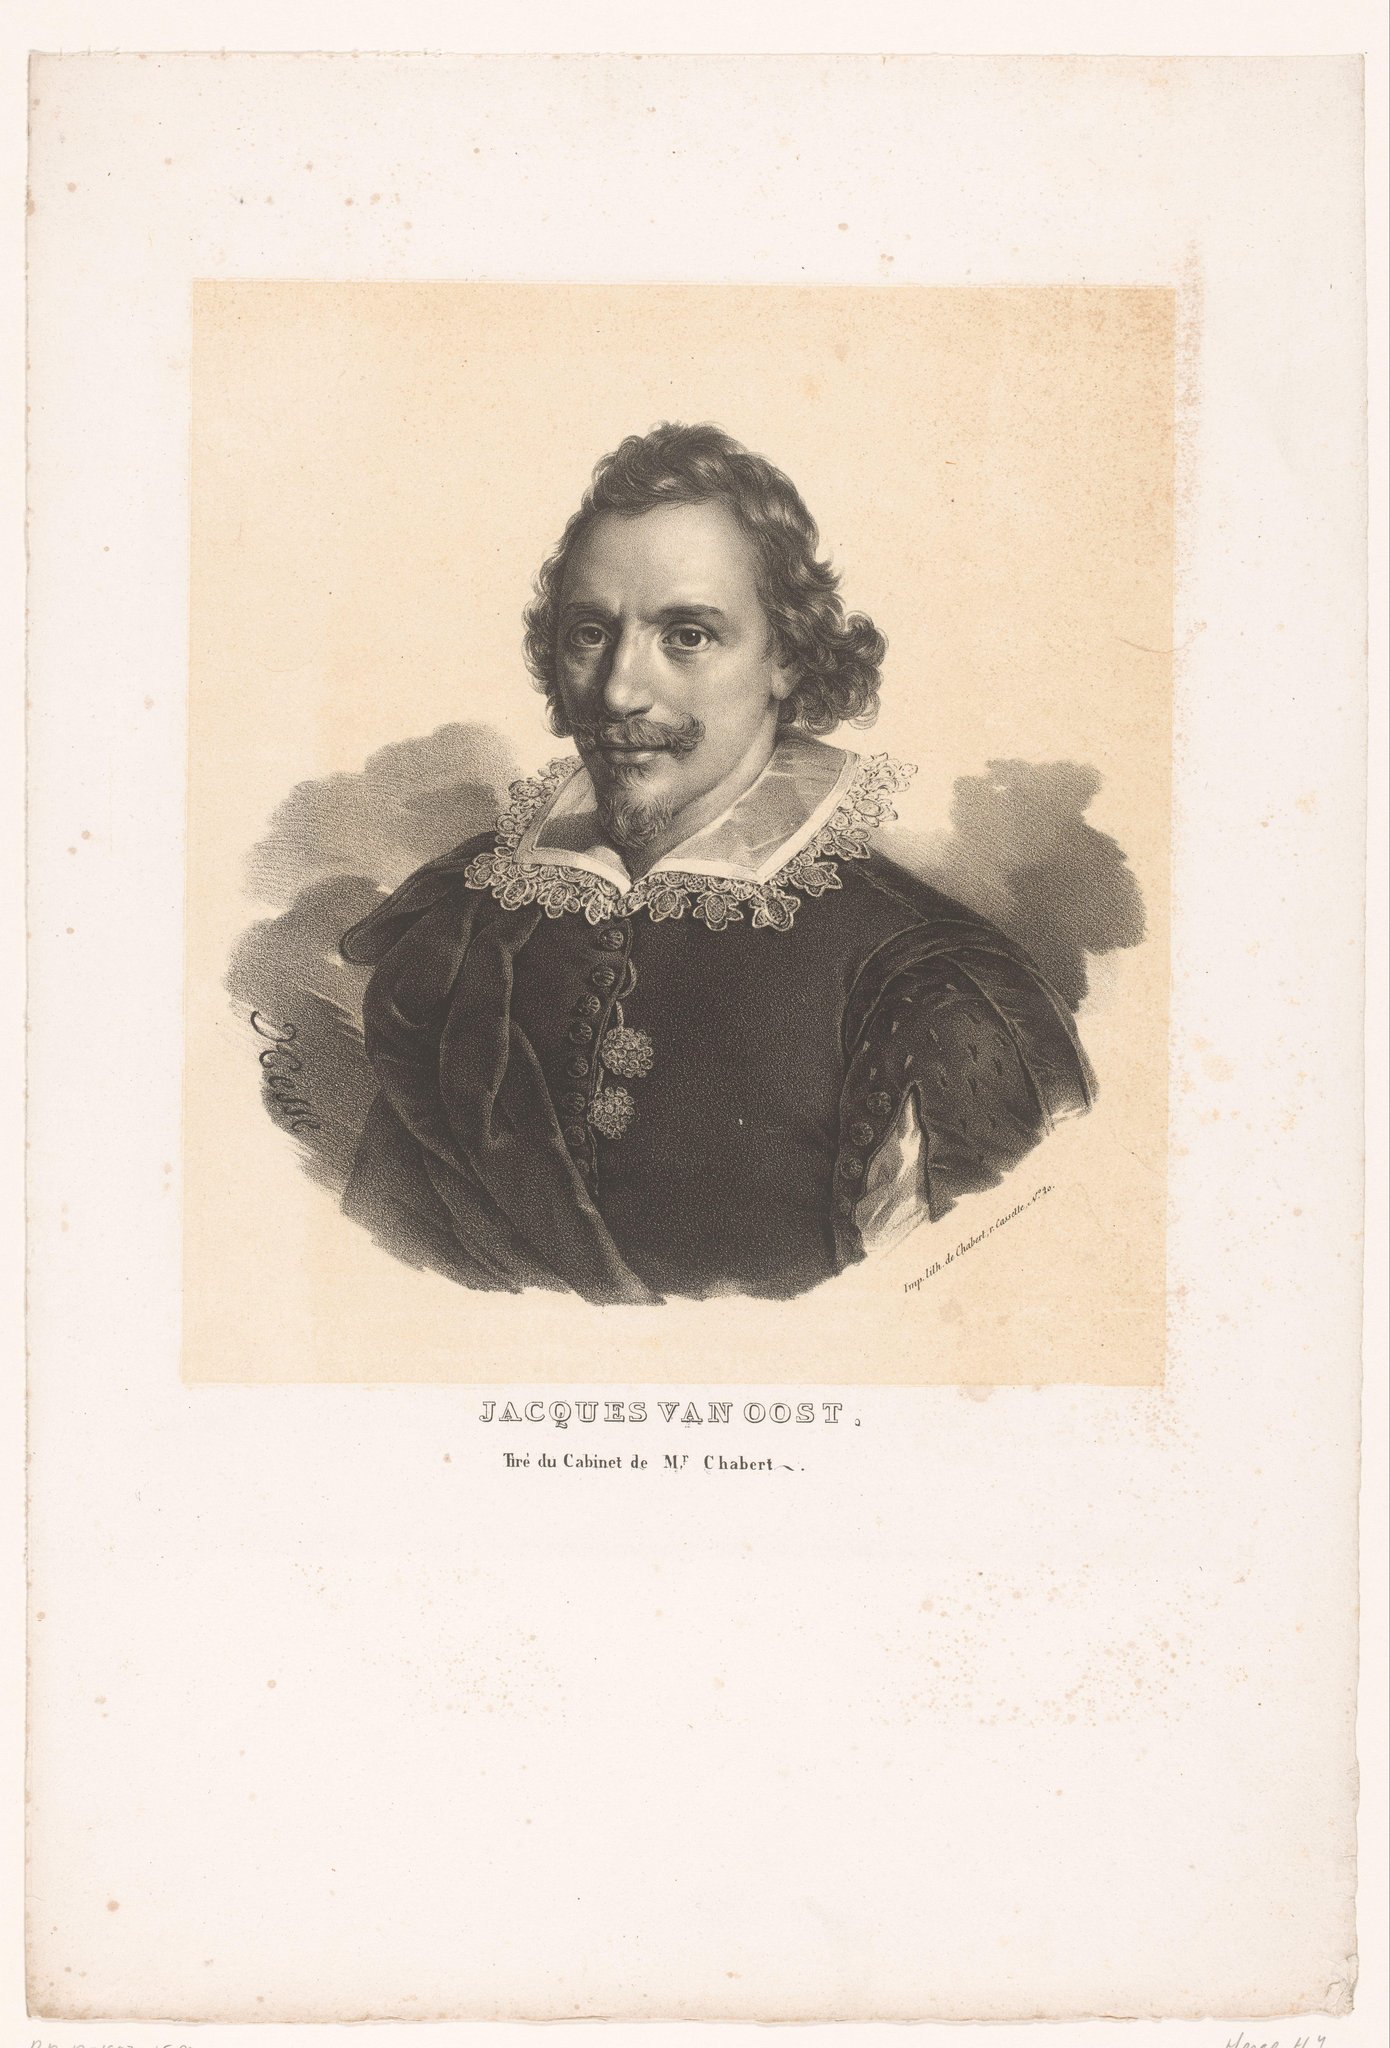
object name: print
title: Jacques van Oost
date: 1822-1854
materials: paper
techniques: lithograph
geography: paris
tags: bruges, painter, print maker, jacob van oost (i), historical persons, portrait, self-portrait of painter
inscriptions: collector's mark: Lugt 2228a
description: Prent waarschijnlijk ook gebruikt in: Chabert, Jean Claude. Galerie des peintres ou collection de portraits des peintres les plus célèbres de toutes les écoles. Accompagnée d'une notice sur chacun d'eux, et de copies de dessins originaux / Galerie des peintres ou collection de portraits des peintres les plus célèbres de toutes les écoles. Accompagnée de leur notice historique, de leurs dessins et d'un discours sur les arts. Parijs: Jean Claude Chabert, s.a. [1822-1834]. De samenstelling van tegenwoordig bekende en al dan niet gebonden exemplaren van deze uitgave verschillen. Dit omdat de prenten en bijhorende stukken tekst op inschrijving en waarschijnlijk ook los verkrijgbaar waren.